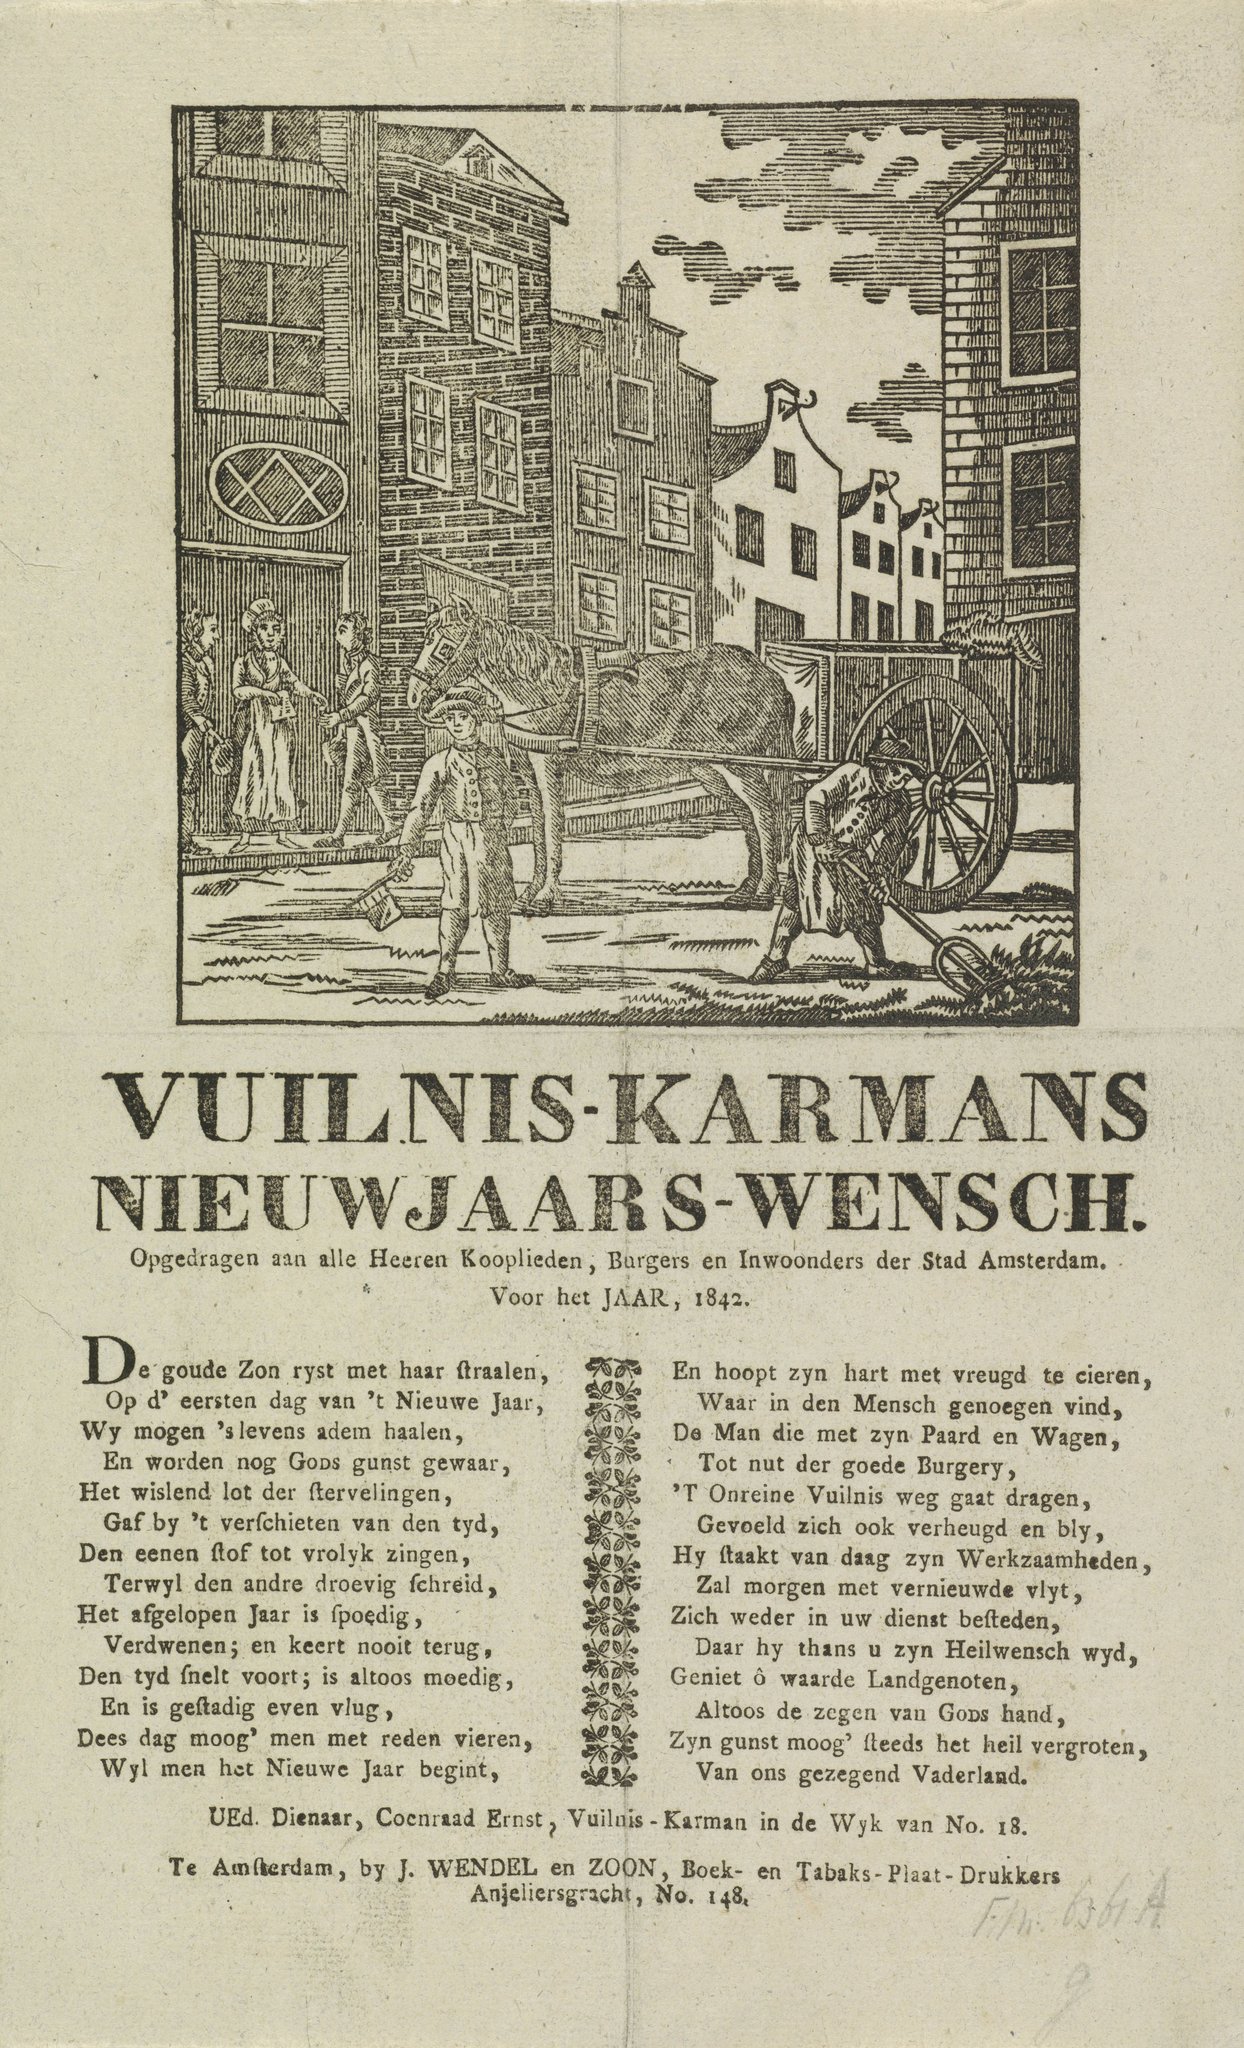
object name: print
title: Vuilnis-karmans nieuwjaars-wensch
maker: Anonymous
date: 1841-1842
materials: paper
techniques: letterpress printing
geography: amsterdam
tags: street, garbage collection, amsterdam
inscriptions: collector's mark: Lugt 2228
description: Nieuwjaarswens van de Amsterdamse vuilnismannen voor het jaar 1842. Gezicht in een straat te Amsterdam waar een man het vuil van de straat schept en een andere man met de ratel draait. Twee andere mannen halen bij een huis geld op. Met gedicht in twee kolommen. Van de vuilniskarman in de wijk no. 18: Coenraad Ernst.